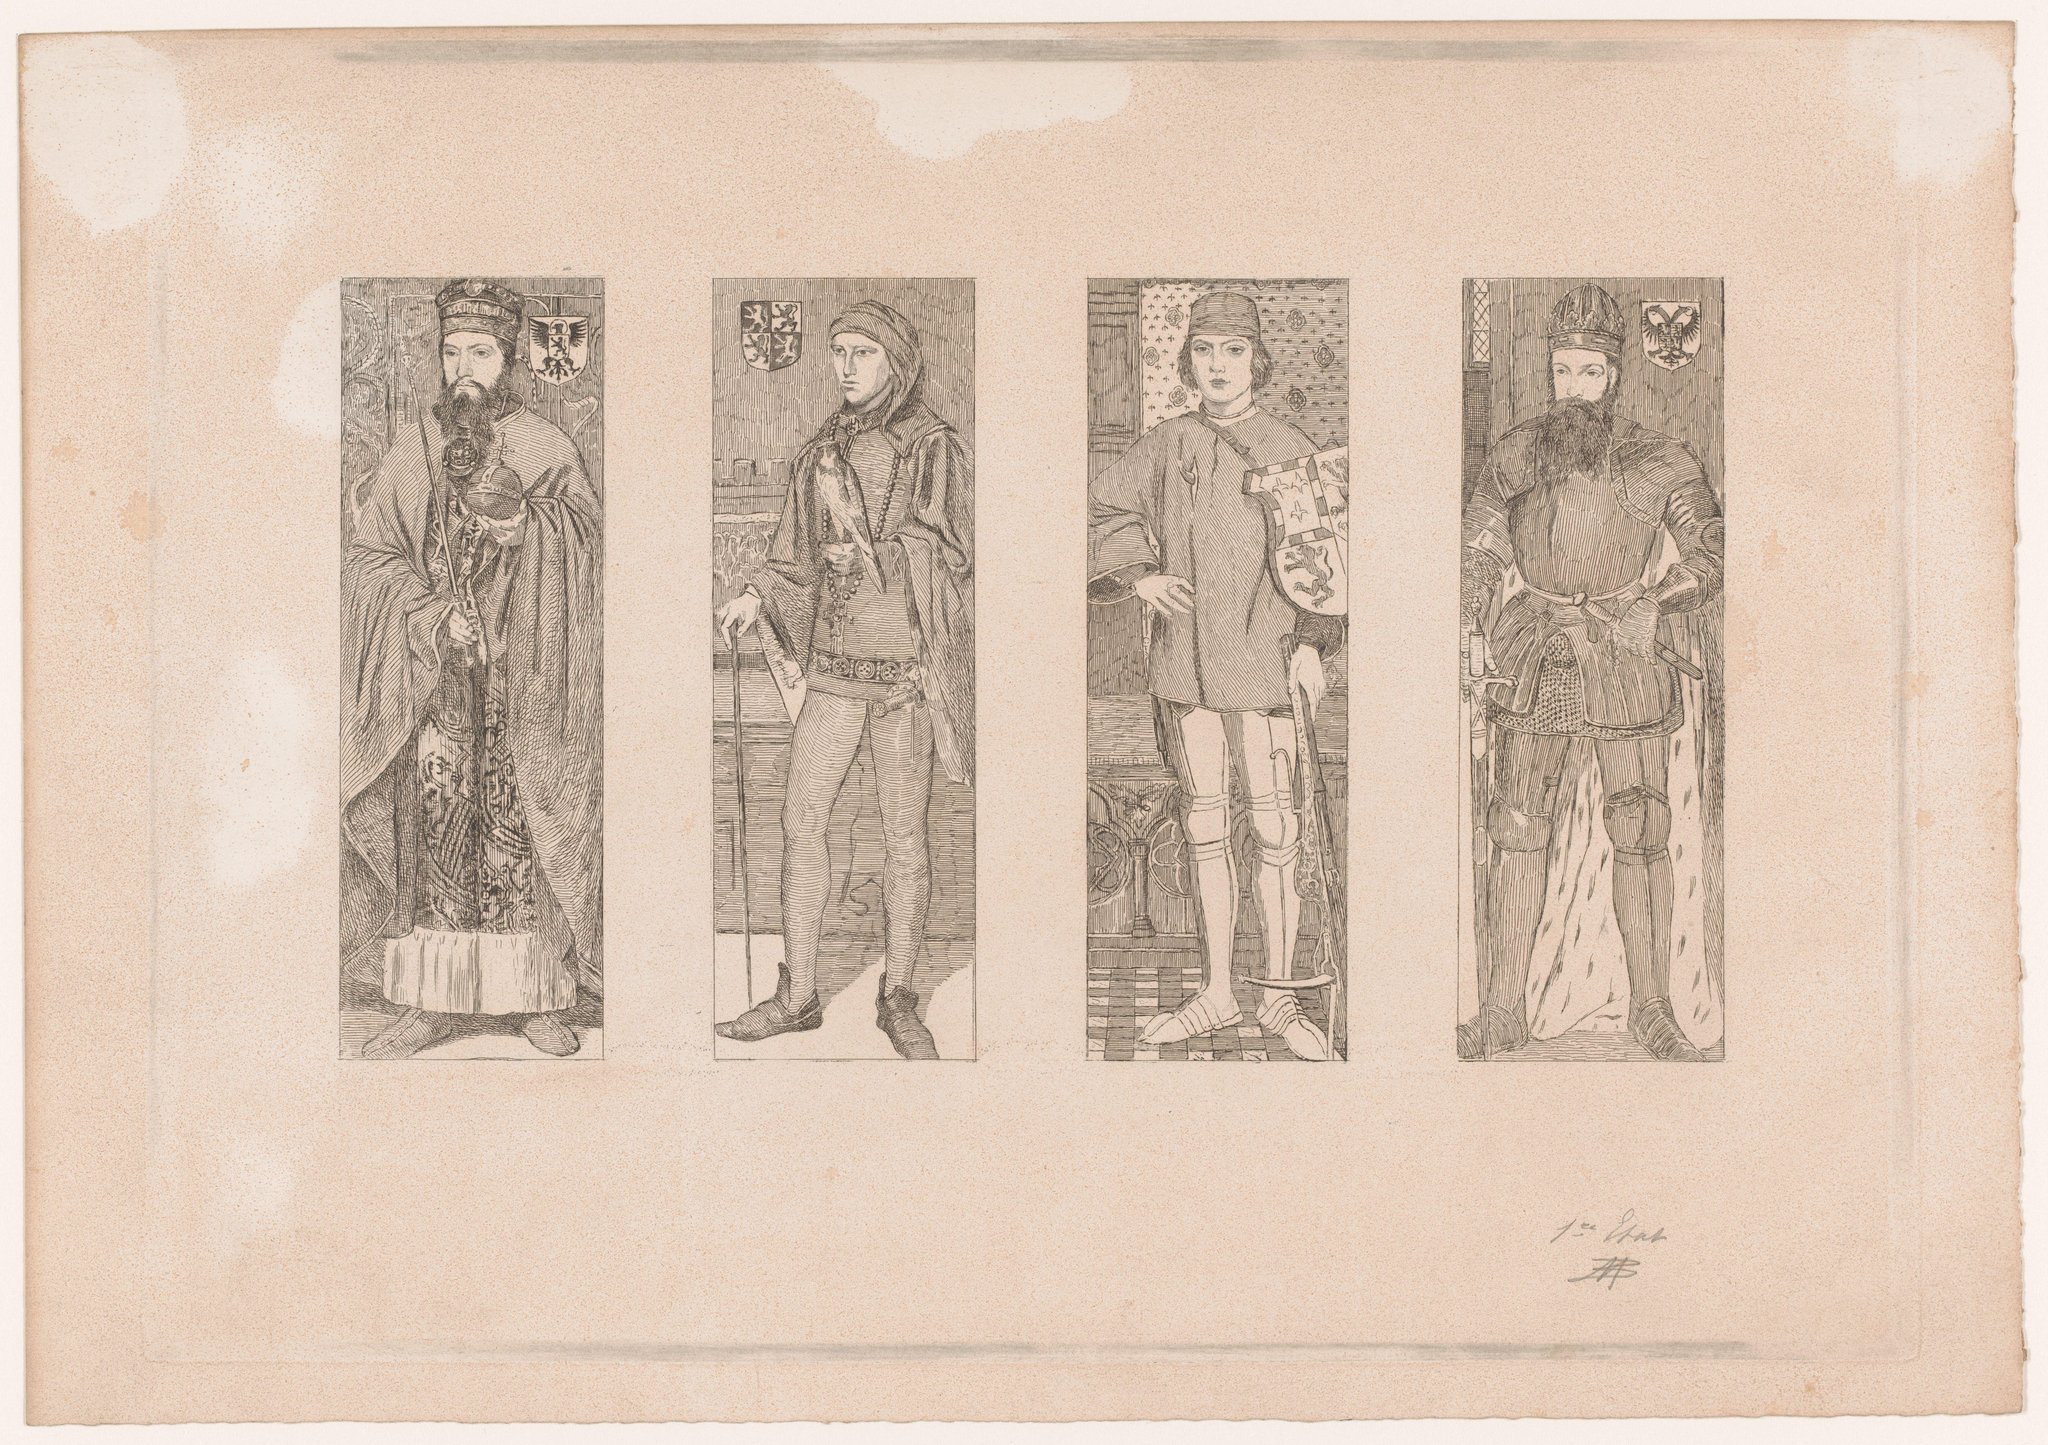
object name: print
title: Vier historische figuren uit de Vlaamse geschiedenis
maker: jean baptiste pierre michiels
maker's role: print maker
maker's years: 1821-1890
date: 1831-1890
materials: paper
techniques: etching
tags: brussels, standing figure, historical persons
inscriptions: collector's mark: Lugt 2228, inscription: ‘1e Etat’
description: De prent is gemaakt naar de muurschilderingen van Henri Leys in het Stadhuis van Antwerpen. Een latere staat van de plaat is gebruikt in: Leys, Henri. De Zaal Leys op het Stadhuis van Antwerpen: zeven kopersneden naar de muurschilderingen van Baron H. Leys. Antwerpen: Museum Plantin-Moretus, 1902.